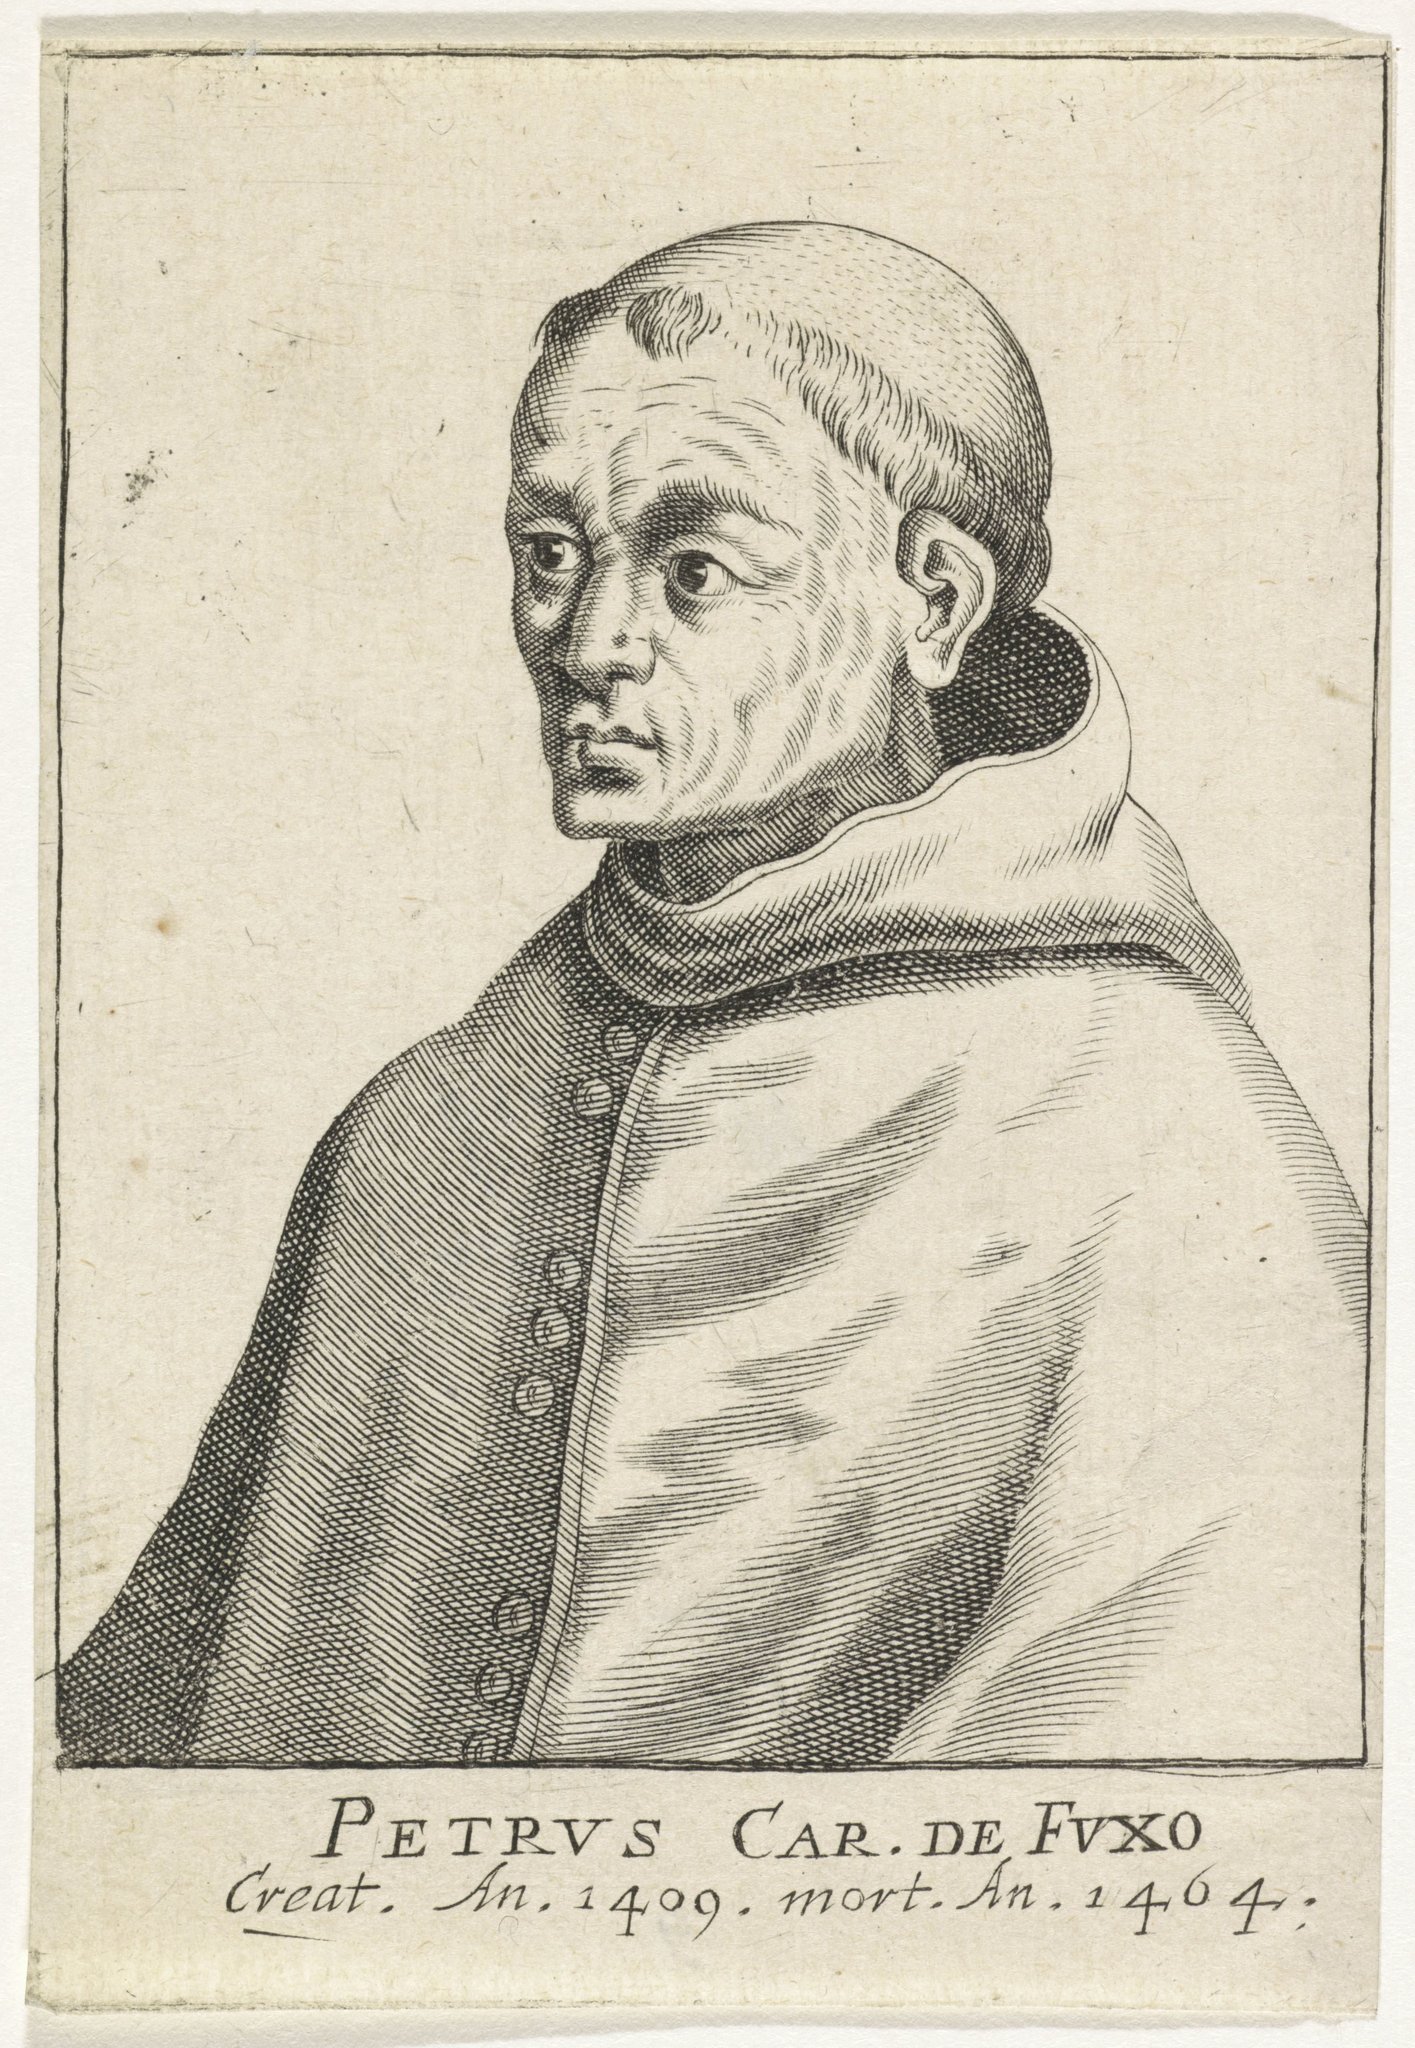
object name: print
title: Portretten van kardinalen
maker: frans van den wijngaerde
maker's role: print maker, publisher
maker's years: 1614-1679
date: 1644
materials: paper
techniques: engraving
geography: antwerp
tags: cardinal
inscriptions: collector's mark: Lugt 2228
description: Prent gebruikt in: Albi, Henri. Eloges historiques des Cardinaux illustres François et etrangers mis en parallele. Parijs: Anthoine de Cay, 1644.